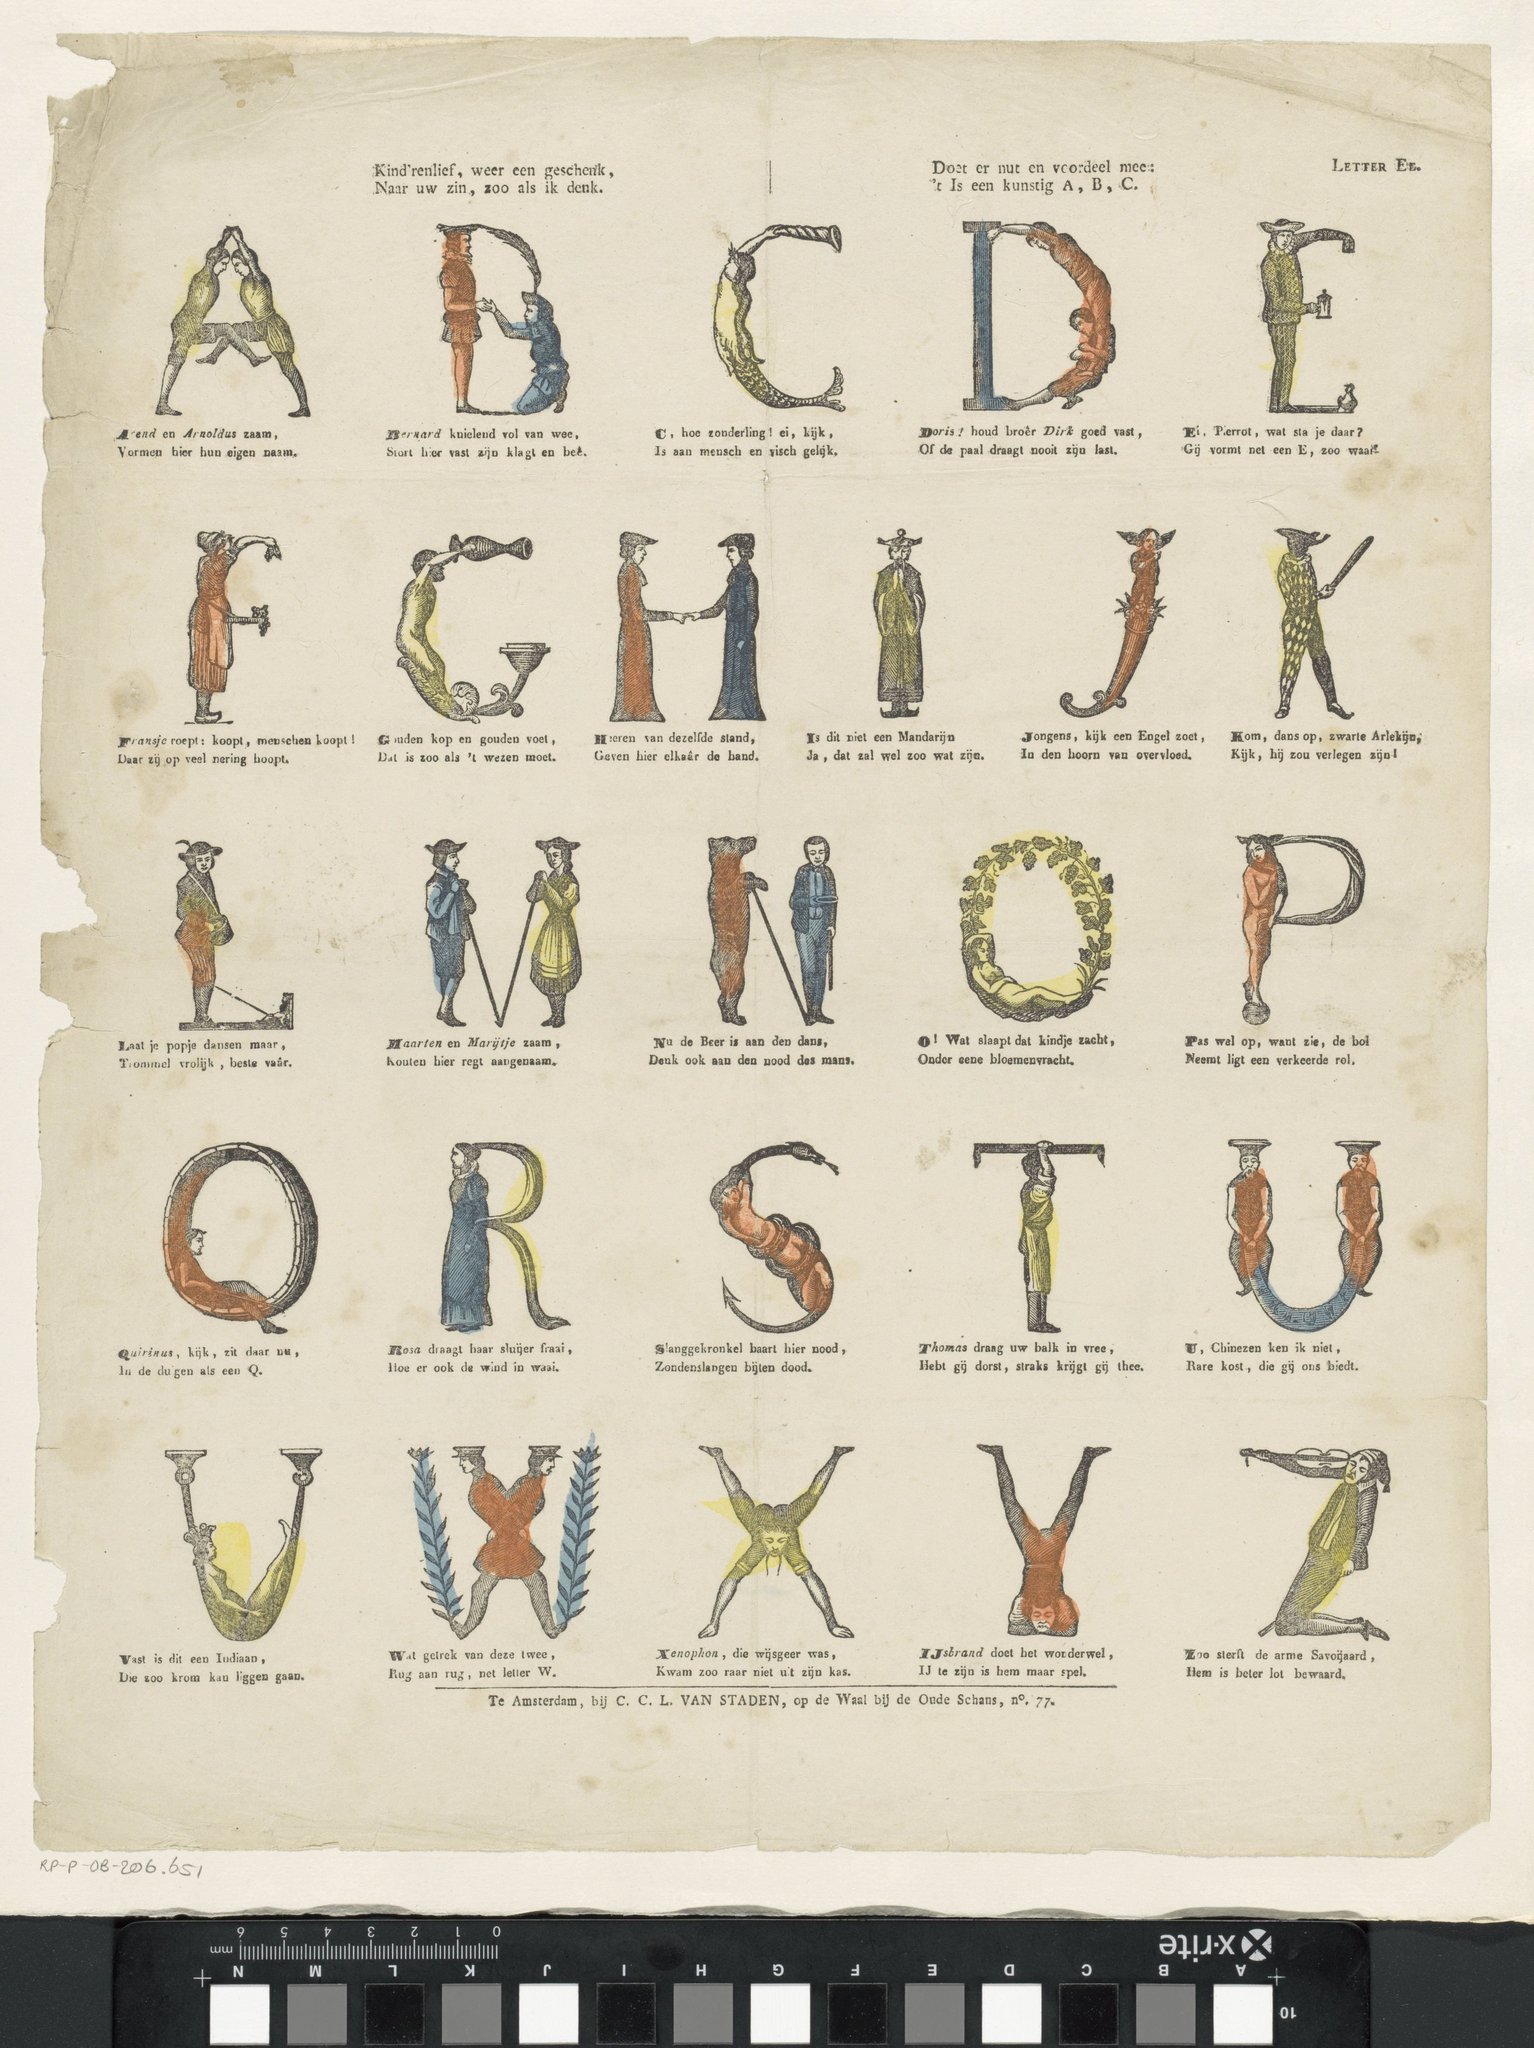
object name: print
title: Kind'renlief, weer een geschenk, / Naar uw zin, zoo als ik denk. / Doet er nut en voordeel mee: / 't is een kunstig A, B, C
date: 1822-1870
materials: paper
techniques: colour, letterpress printing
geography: amsterdam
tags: letters, alphabet, script, fancy letters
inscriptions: collector's mark: Lugt 2760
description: Blad met 26 voorstellingen van de letters van het alfabet uitgebeeld door menselijke figuren. Onder elke afbeelding een tweeregelig vers. Rechtsboven gemerkt: Letter EE.